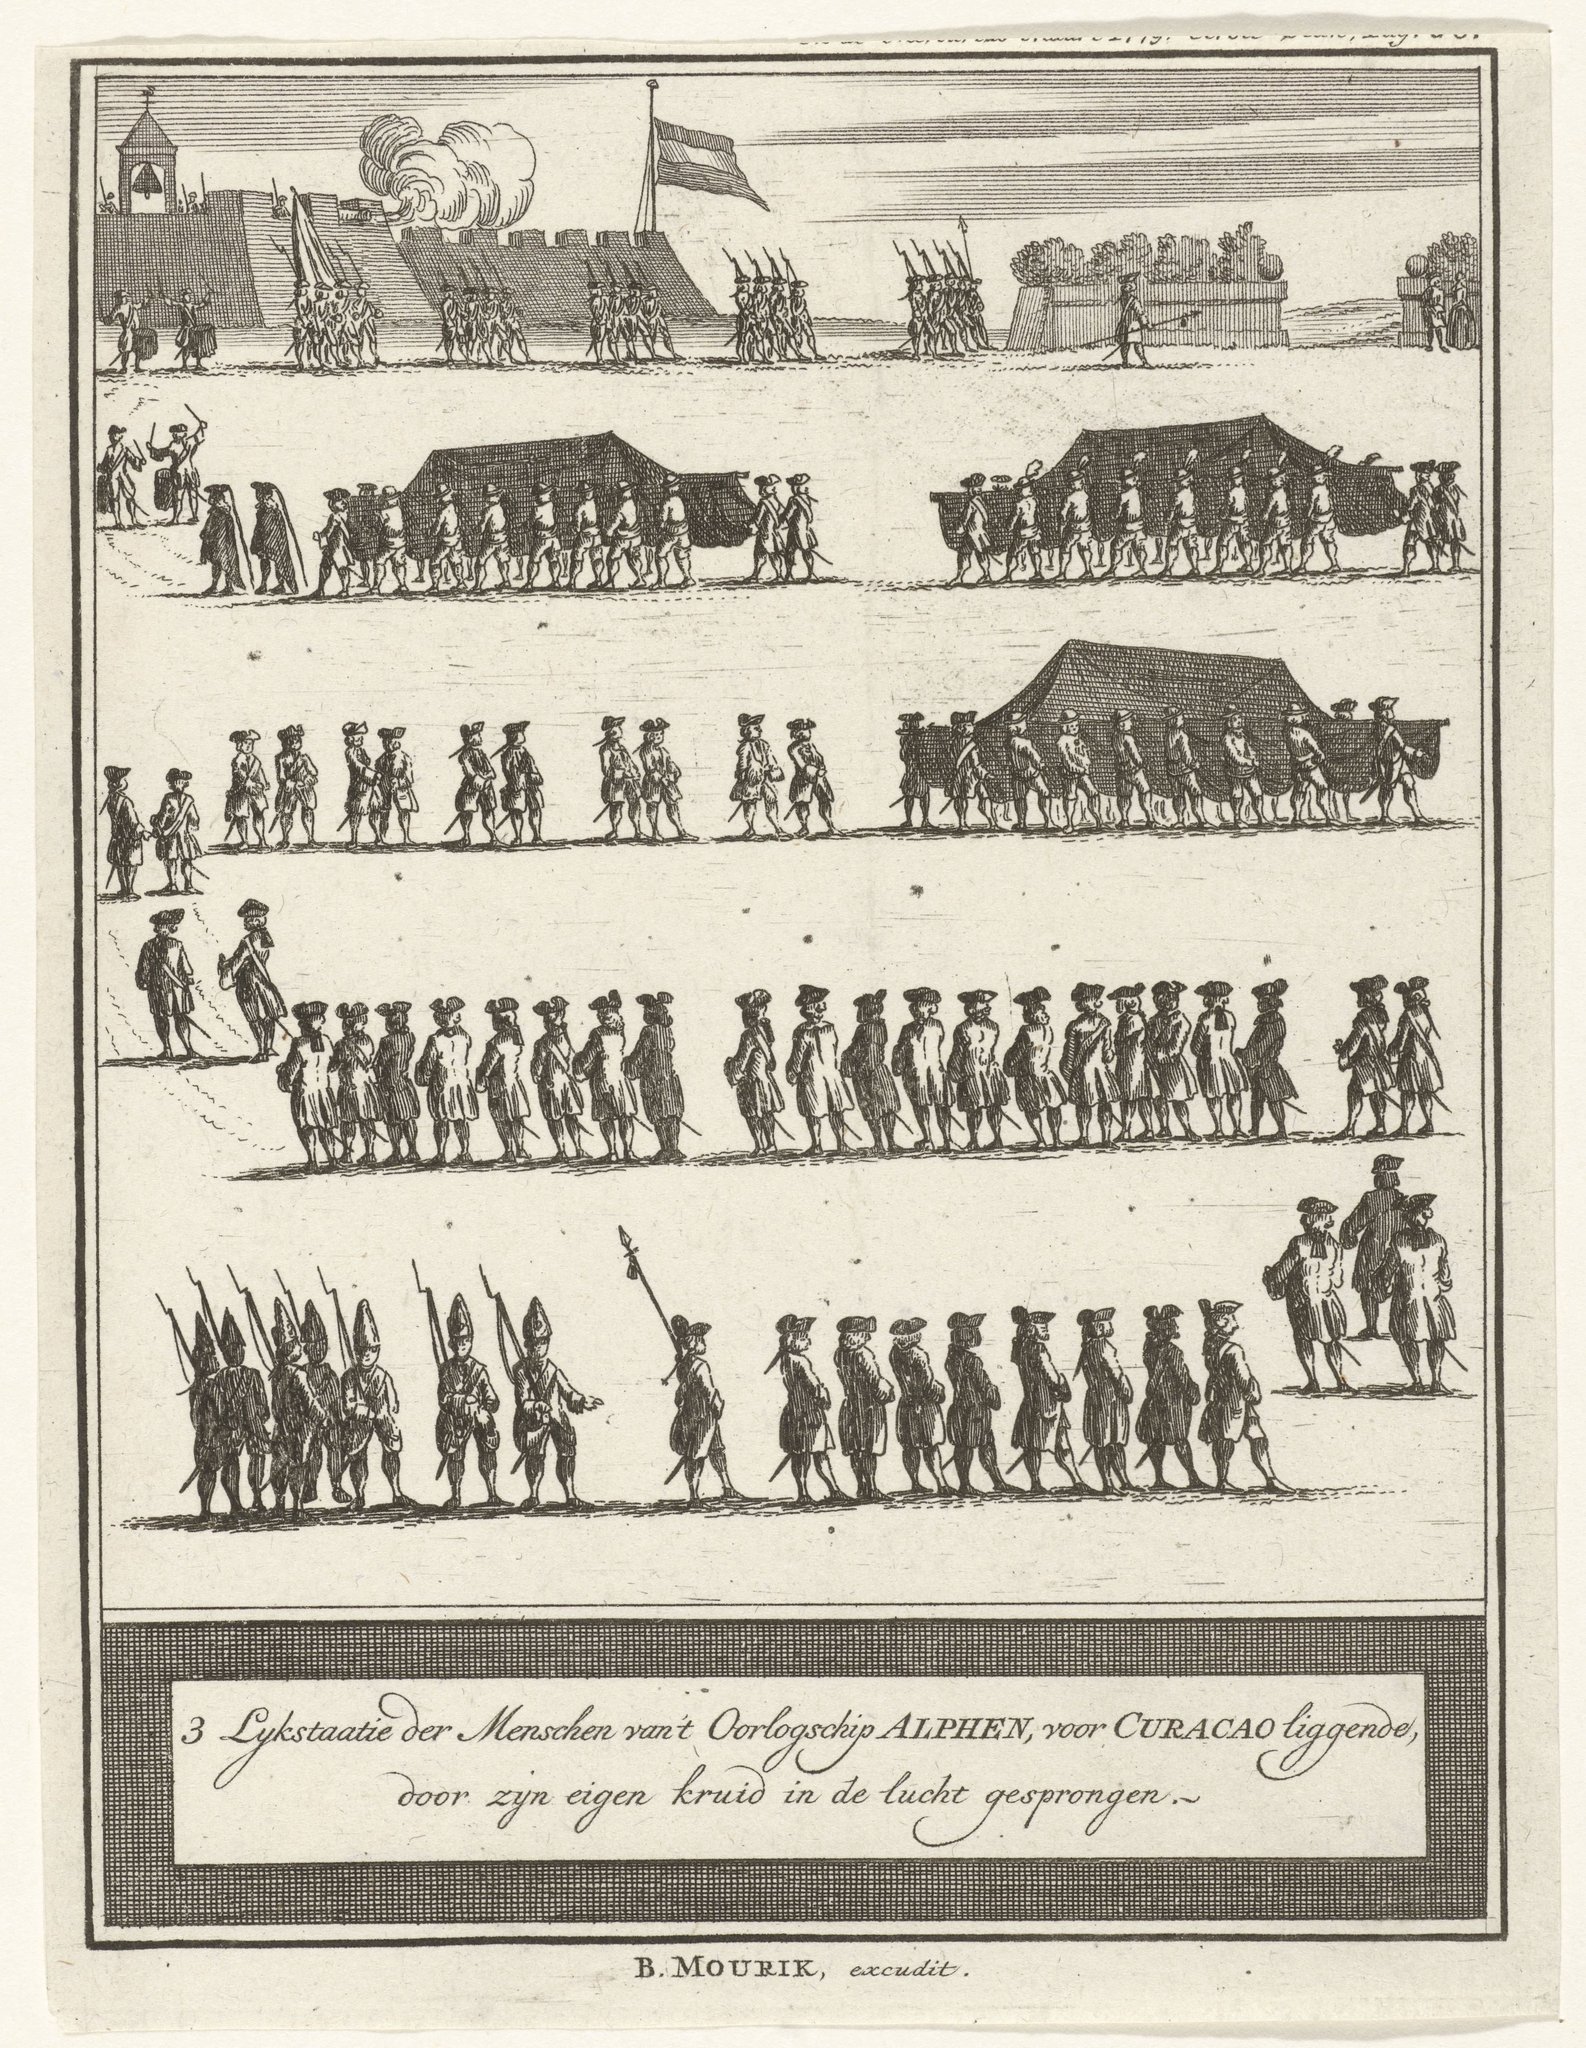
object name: print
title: 3 Lykstaatie der Menschen van't Oorlogschip Alphen, voor Curacao liggende, door zijn eigen kruid in de lucht gesprongen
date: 1779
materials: paper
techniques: engraving, etching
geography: northern netherlands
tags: cortege, funeral procession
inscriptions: collector's mark: Lugt 2228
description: Drie begrafenisstoeten van de slachtoffers van de ontploffing van het fregat Alphen in de haven van Curaçao, 15 september 1778. In een optocht worden de stoffelijke resten naar het Fort Amsterdam gedragen.